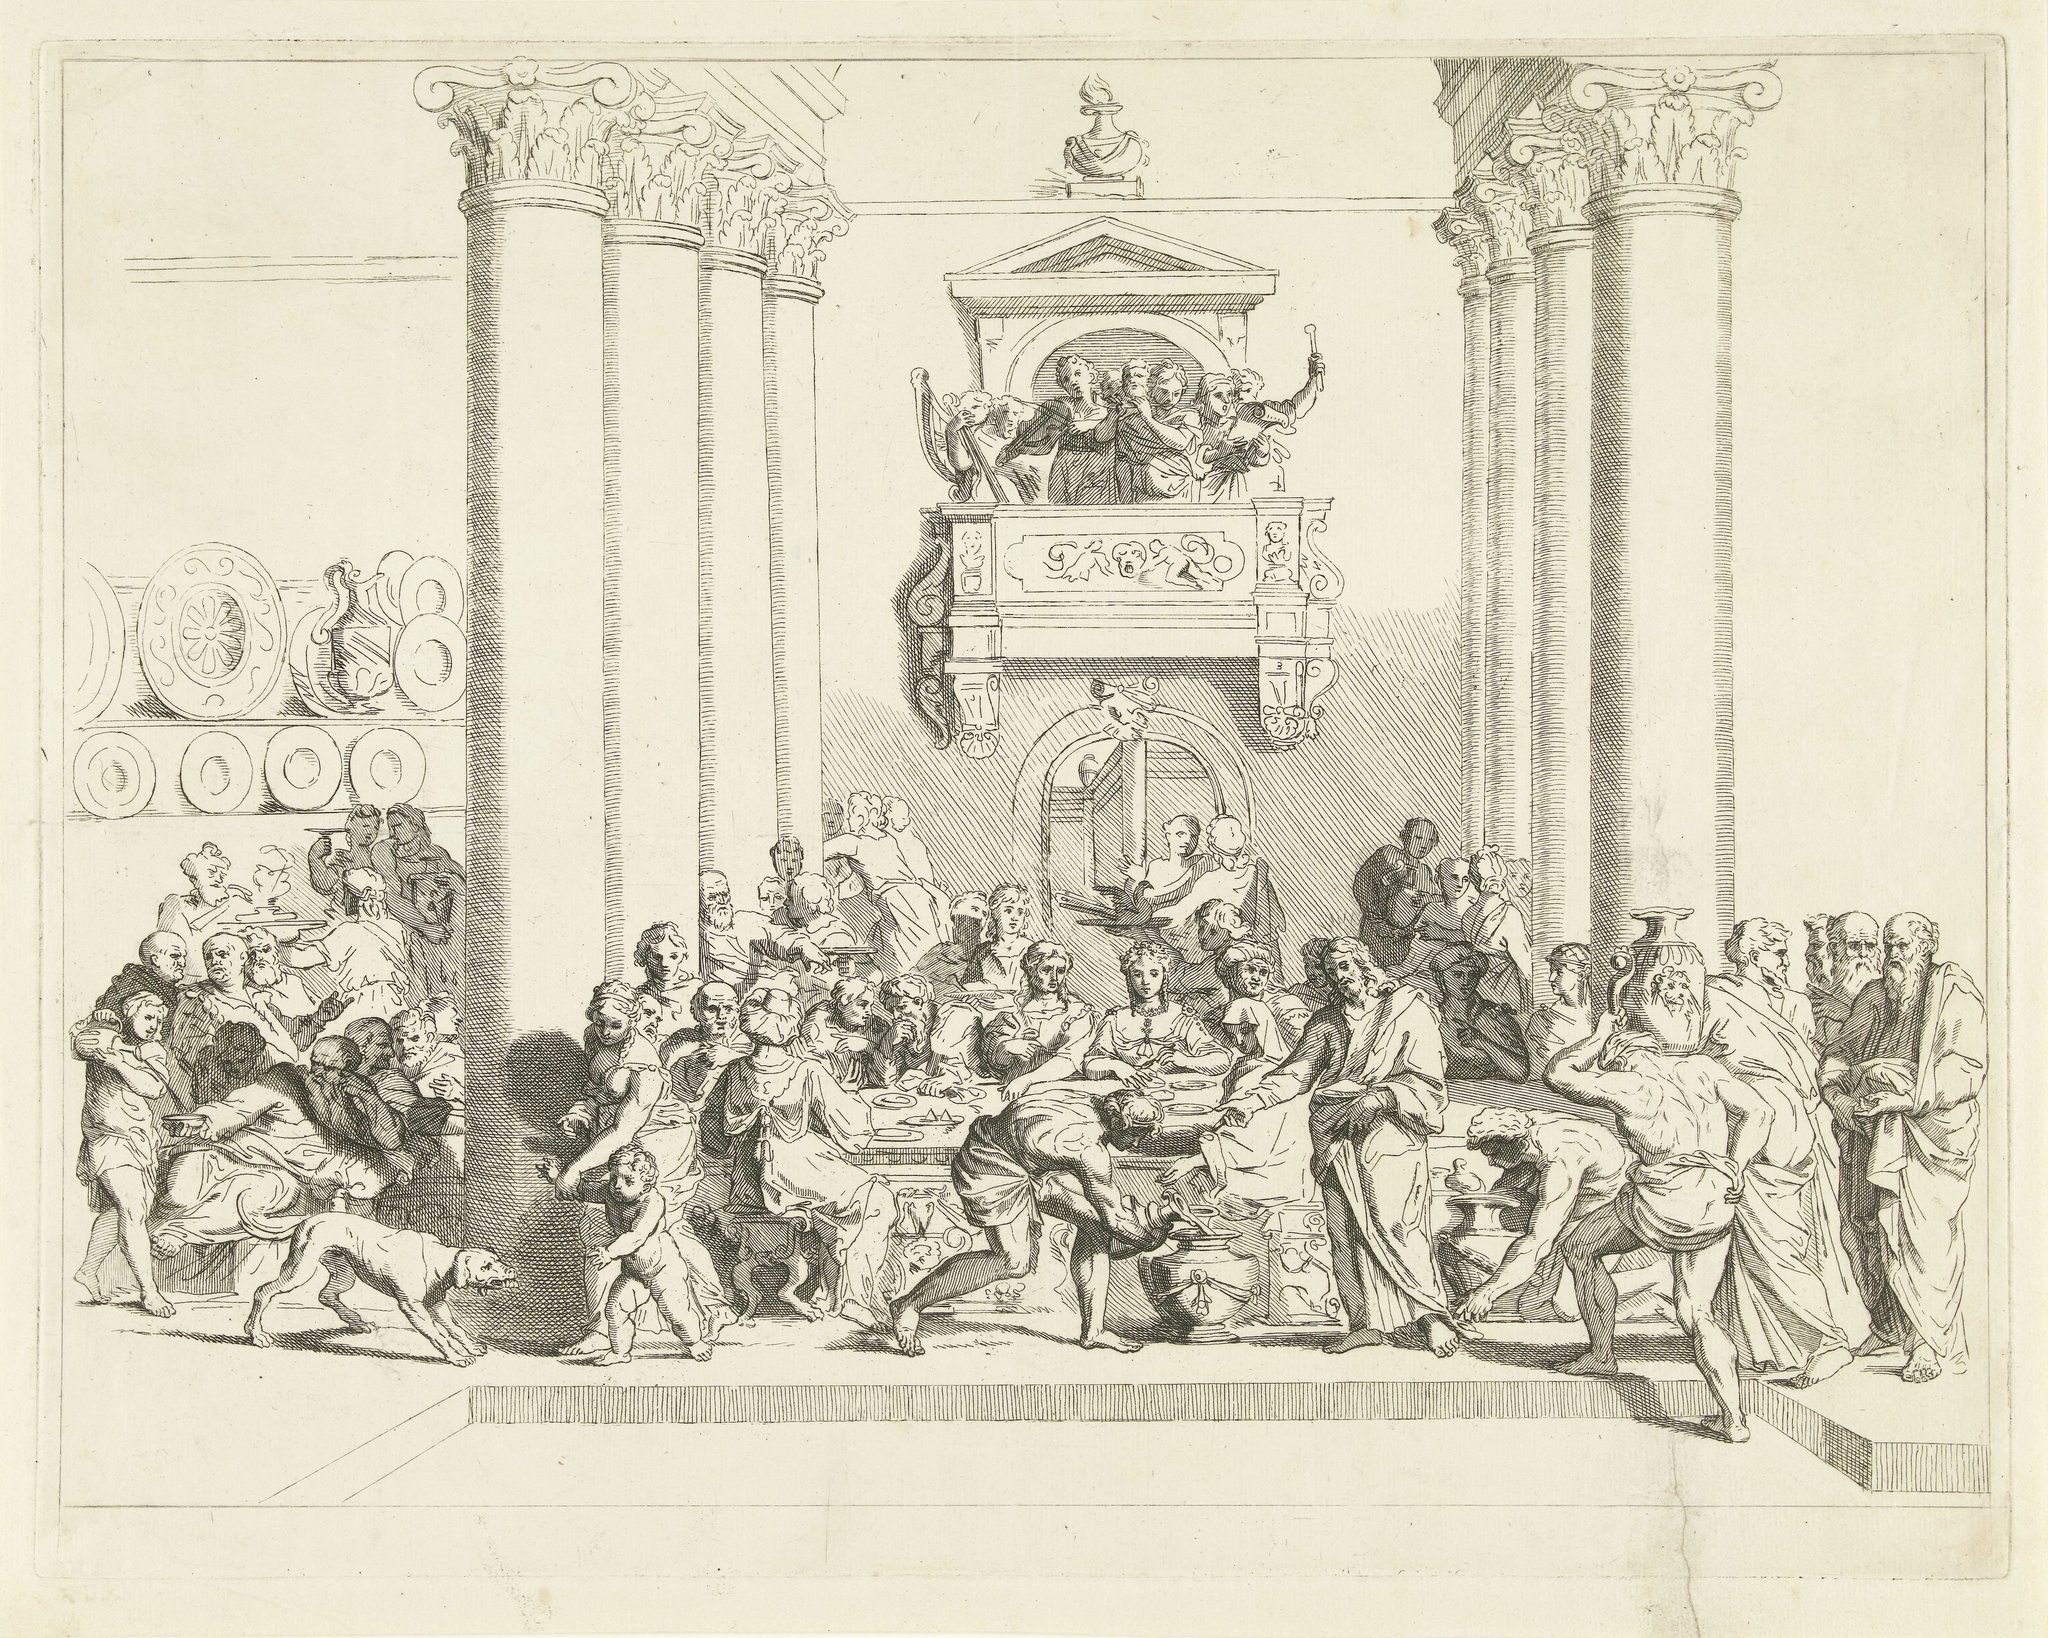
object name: print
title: Bruiloft te Kana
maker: franz ertinger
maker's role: print maker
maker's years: 1640-1710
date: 1689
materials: paper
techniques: etching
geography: paris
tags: christ orders (six) jars to be filled with water ~ marriage-feast at cana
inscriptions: collector's mark: Lugt 2165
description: Tijdens het diner van de bruiloft te Kana laat Christus stenen vaten met water vullen, waarna hij het in wijn verandert. Aan tafel, in het midden, de bruid. Boven haar hoofd een duif en op het balkon een musicerend en zingend gezelschap. Joh. 2:1-11.